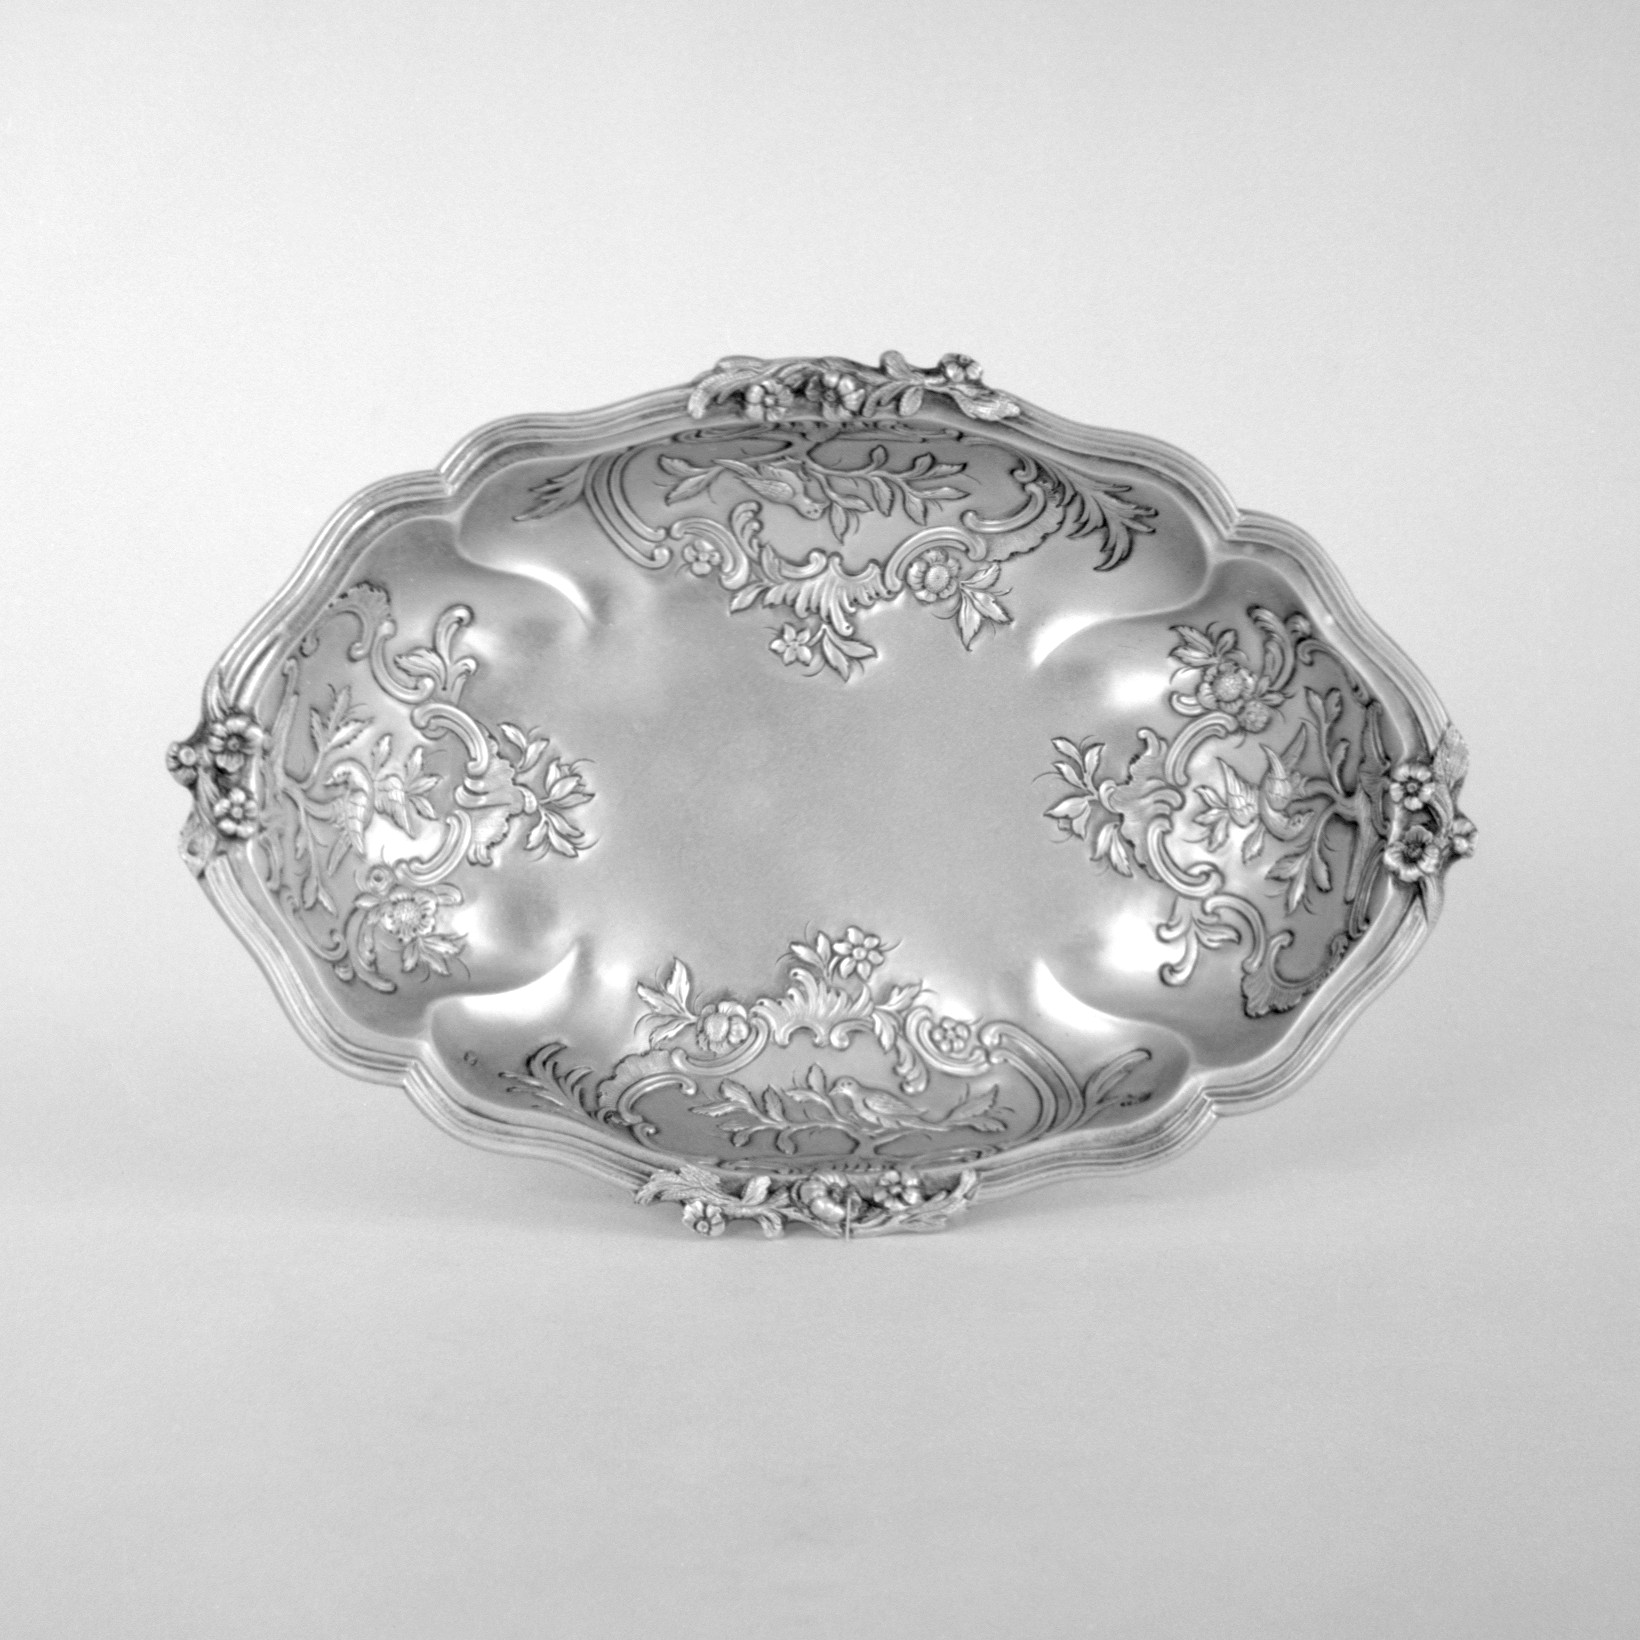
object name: dish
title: Oval dish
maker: johann martin satzger i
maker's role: maker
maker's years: 1707-1785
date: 1761-1763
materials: silver gilt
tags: birds,flowers